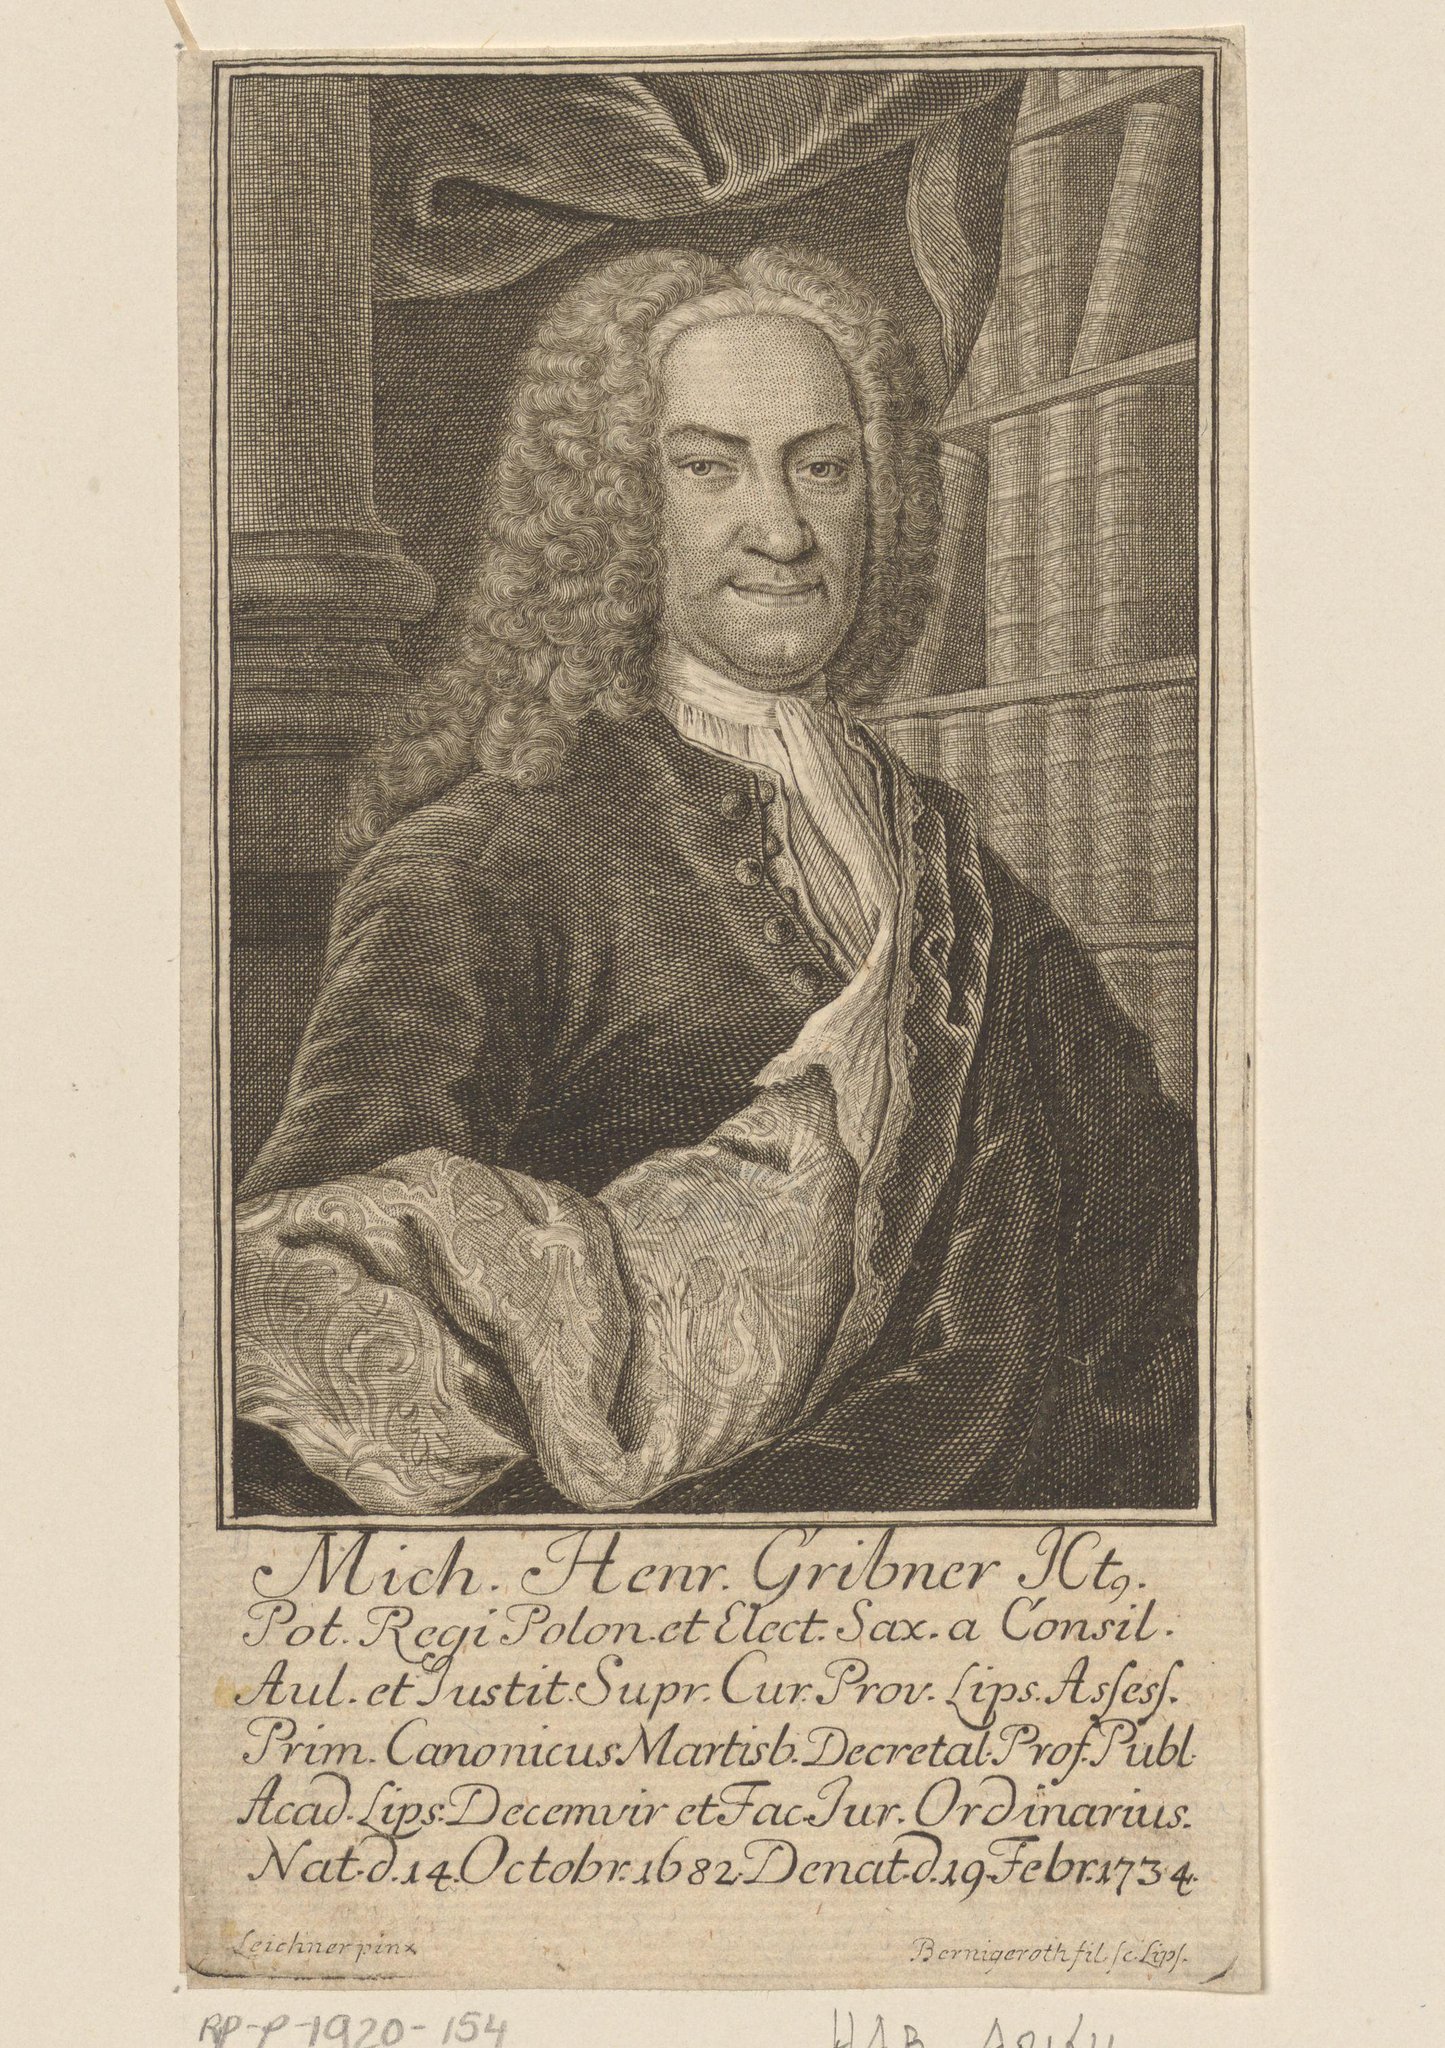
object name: print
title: Portret van Michael Heinrich Griebner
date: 1734-1767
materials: paper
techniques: engraving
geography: leipzig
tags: historical persons, lawyer, attorney at law, professor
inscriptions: collector's mark: Lugt 2228